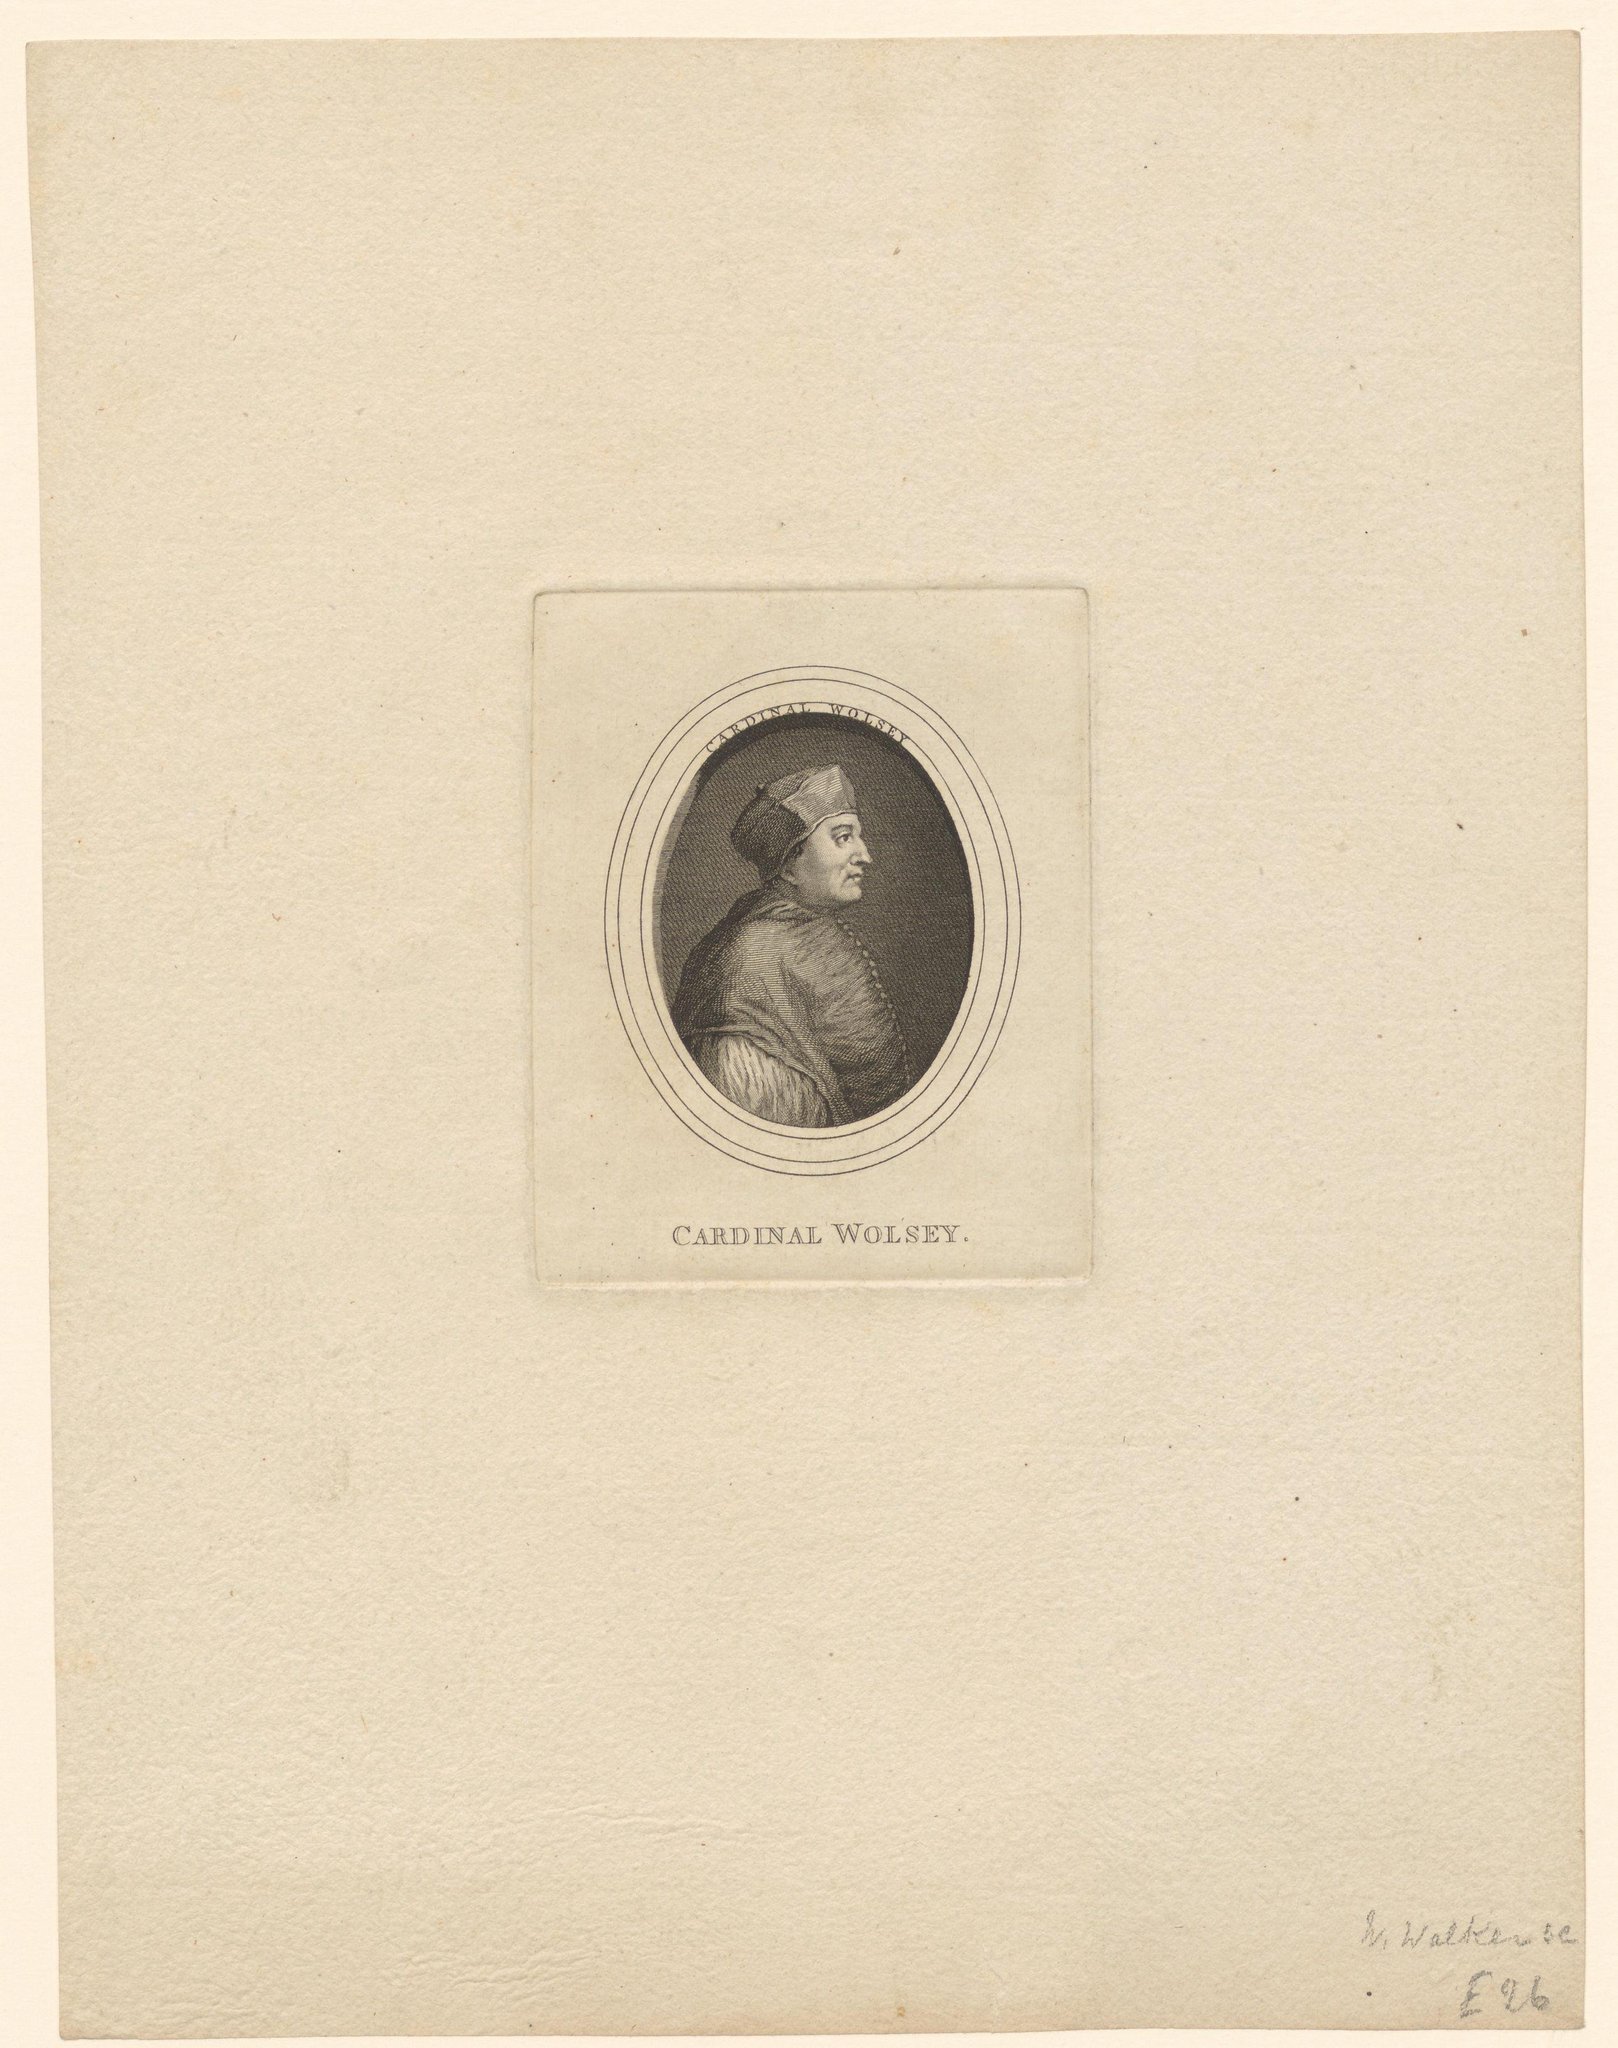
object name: print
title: Portret van Thomas Wolsey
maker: william walker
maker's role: print maker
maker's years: 1729-1793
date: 1739-1793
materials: paper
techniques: engraving, etching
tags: hierarchy of jurisdiction ~ roman catholic church, historical persons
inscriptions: collector's mark: Lugt 2228